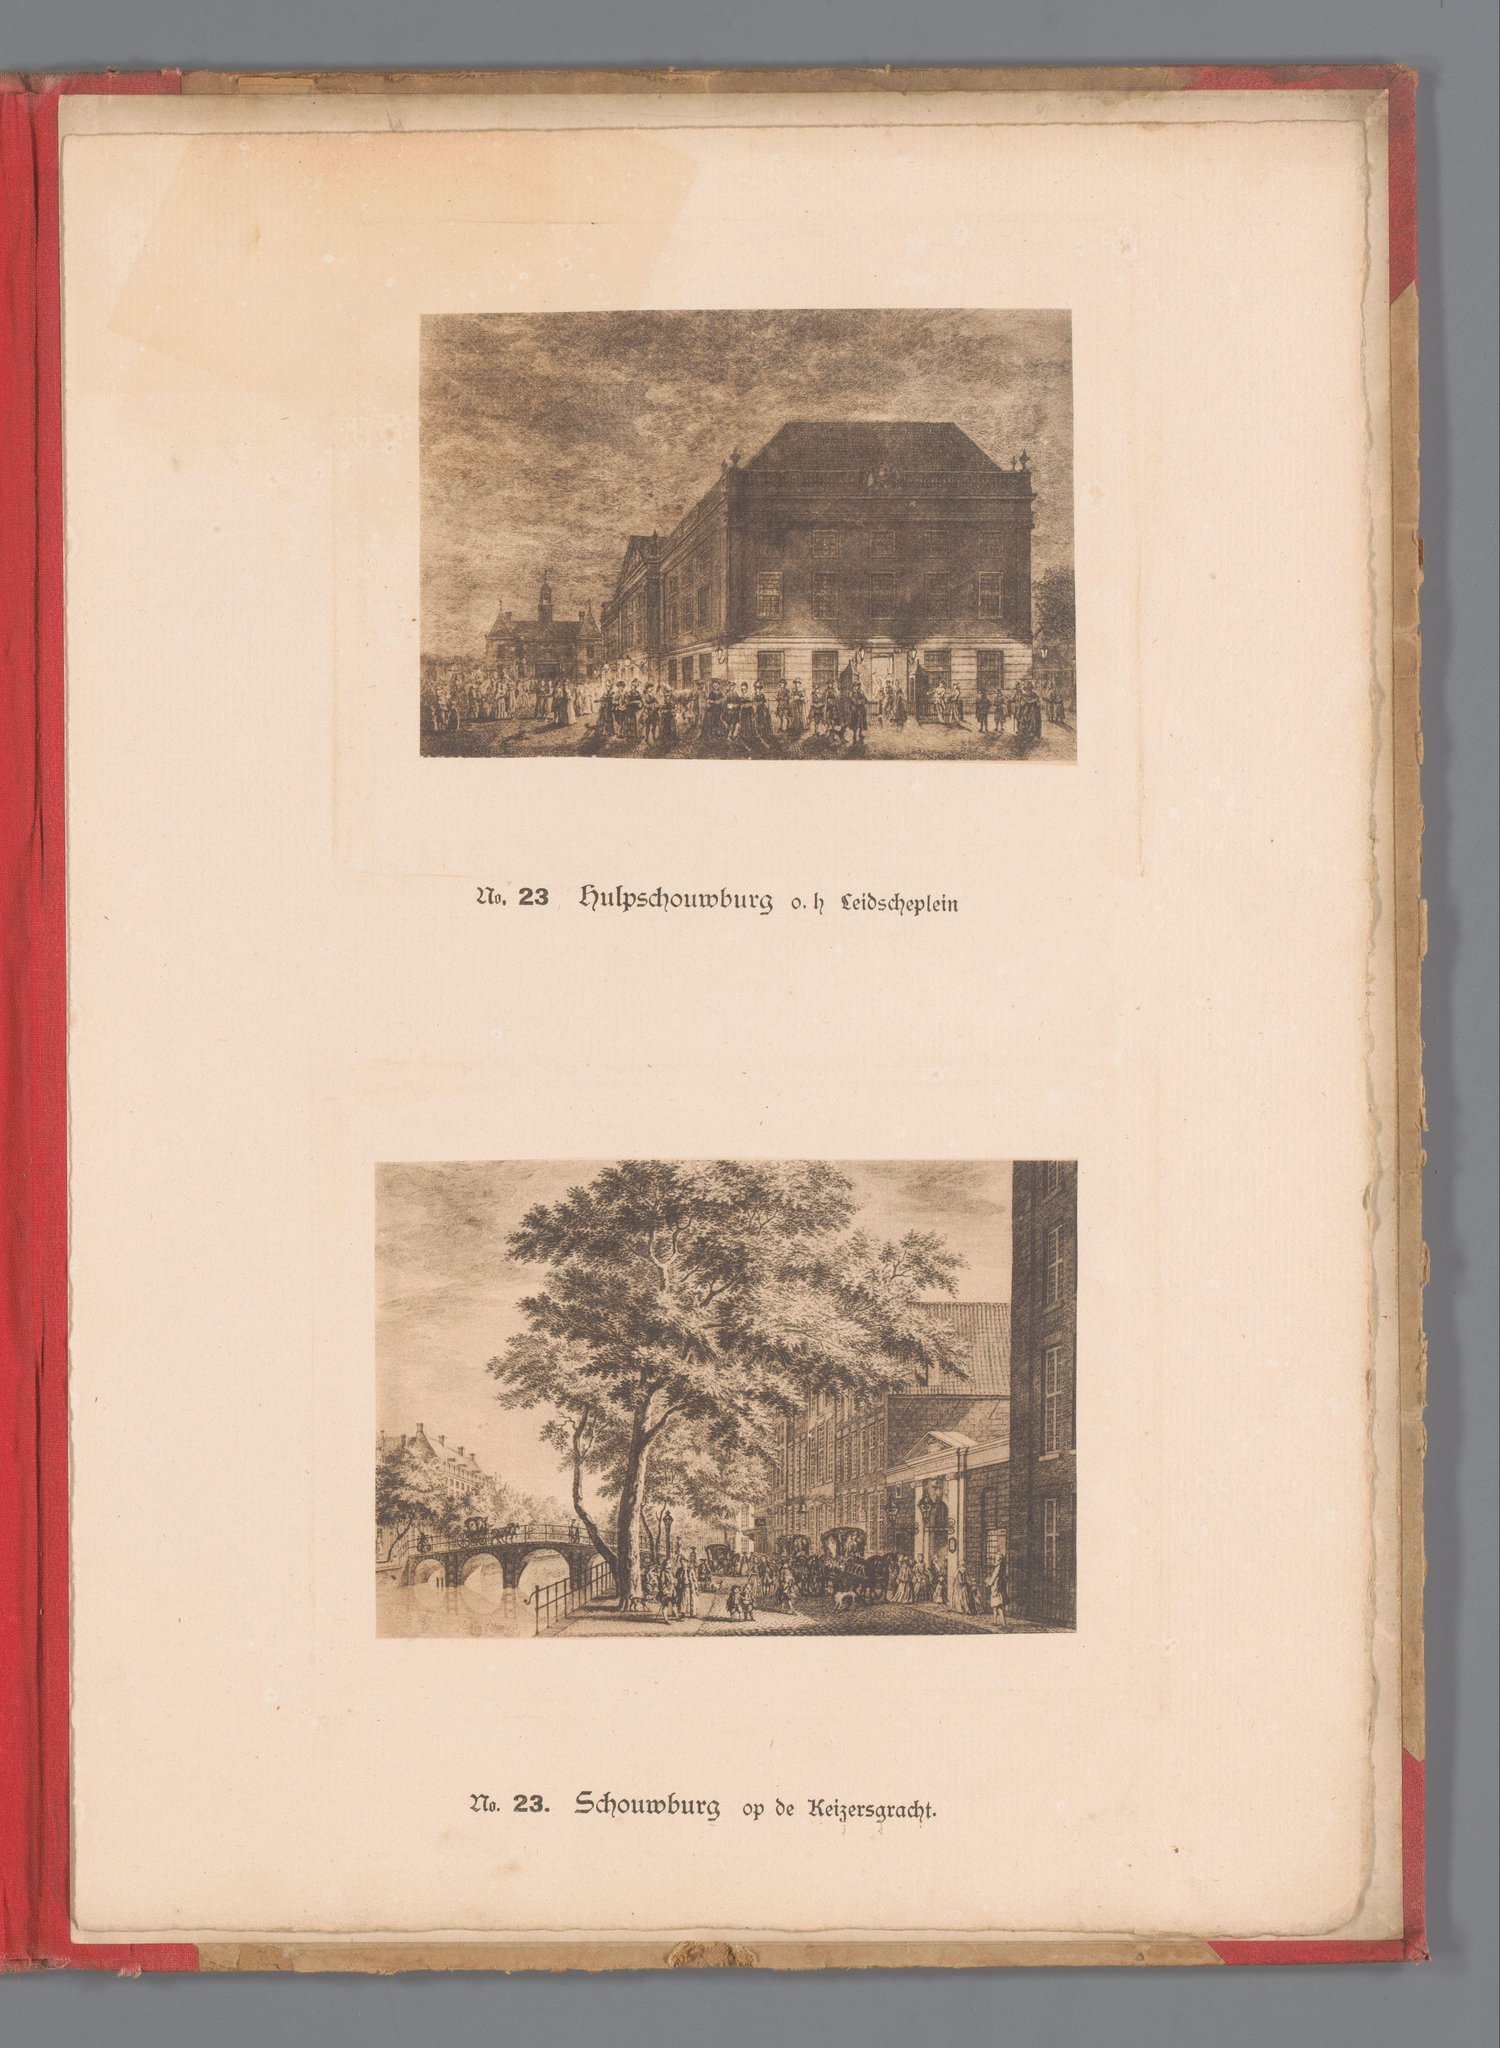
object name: reproduction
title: No. 23. Schouwburg op de Keizersgracht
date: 1890-1900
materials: paper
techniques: photograph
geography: amsterdam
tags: theatre (building), city-gate, square, place, circus, etc. (+ city(-scape) with figures, staffage)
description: Deze prenten maken deel uit van een album.